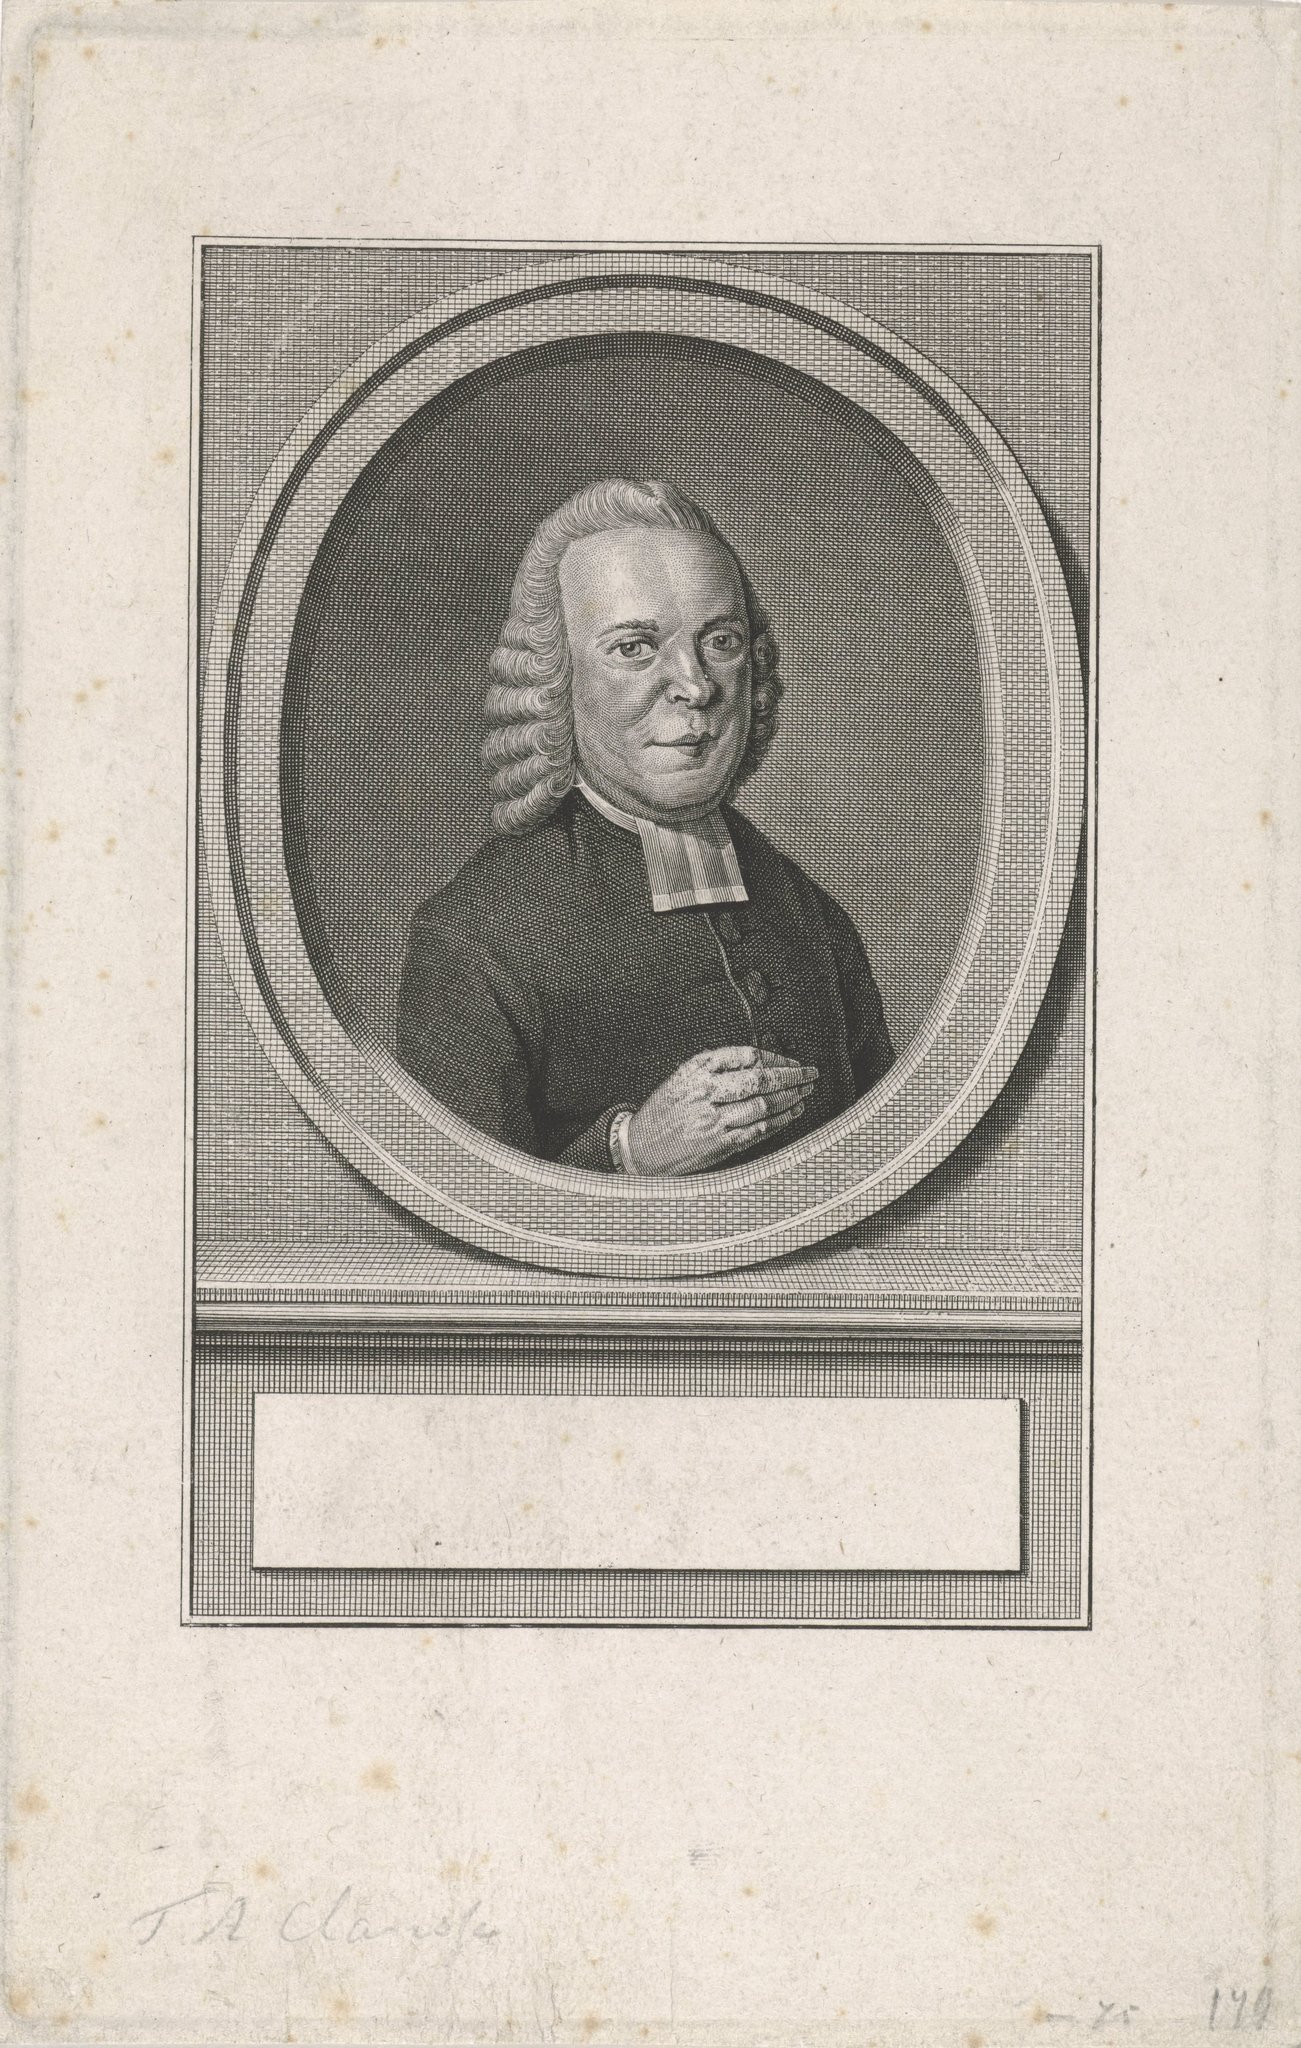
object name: print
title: Portret van Theodorus Adrianus Clarisse (I)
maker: noach van der meer (ii)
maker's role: draughtsman, print maker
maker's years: 1741-1822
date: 1772-1782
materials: paper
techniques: engraving, etching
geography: amsterdam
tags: west-souburg, groningen, predikant, theodorus adrianus clarisse (i)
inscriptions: collector's mark: Lugt 2228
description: Portret van Theodorus Adrianus Clarisse, predikant te Amsterdam.